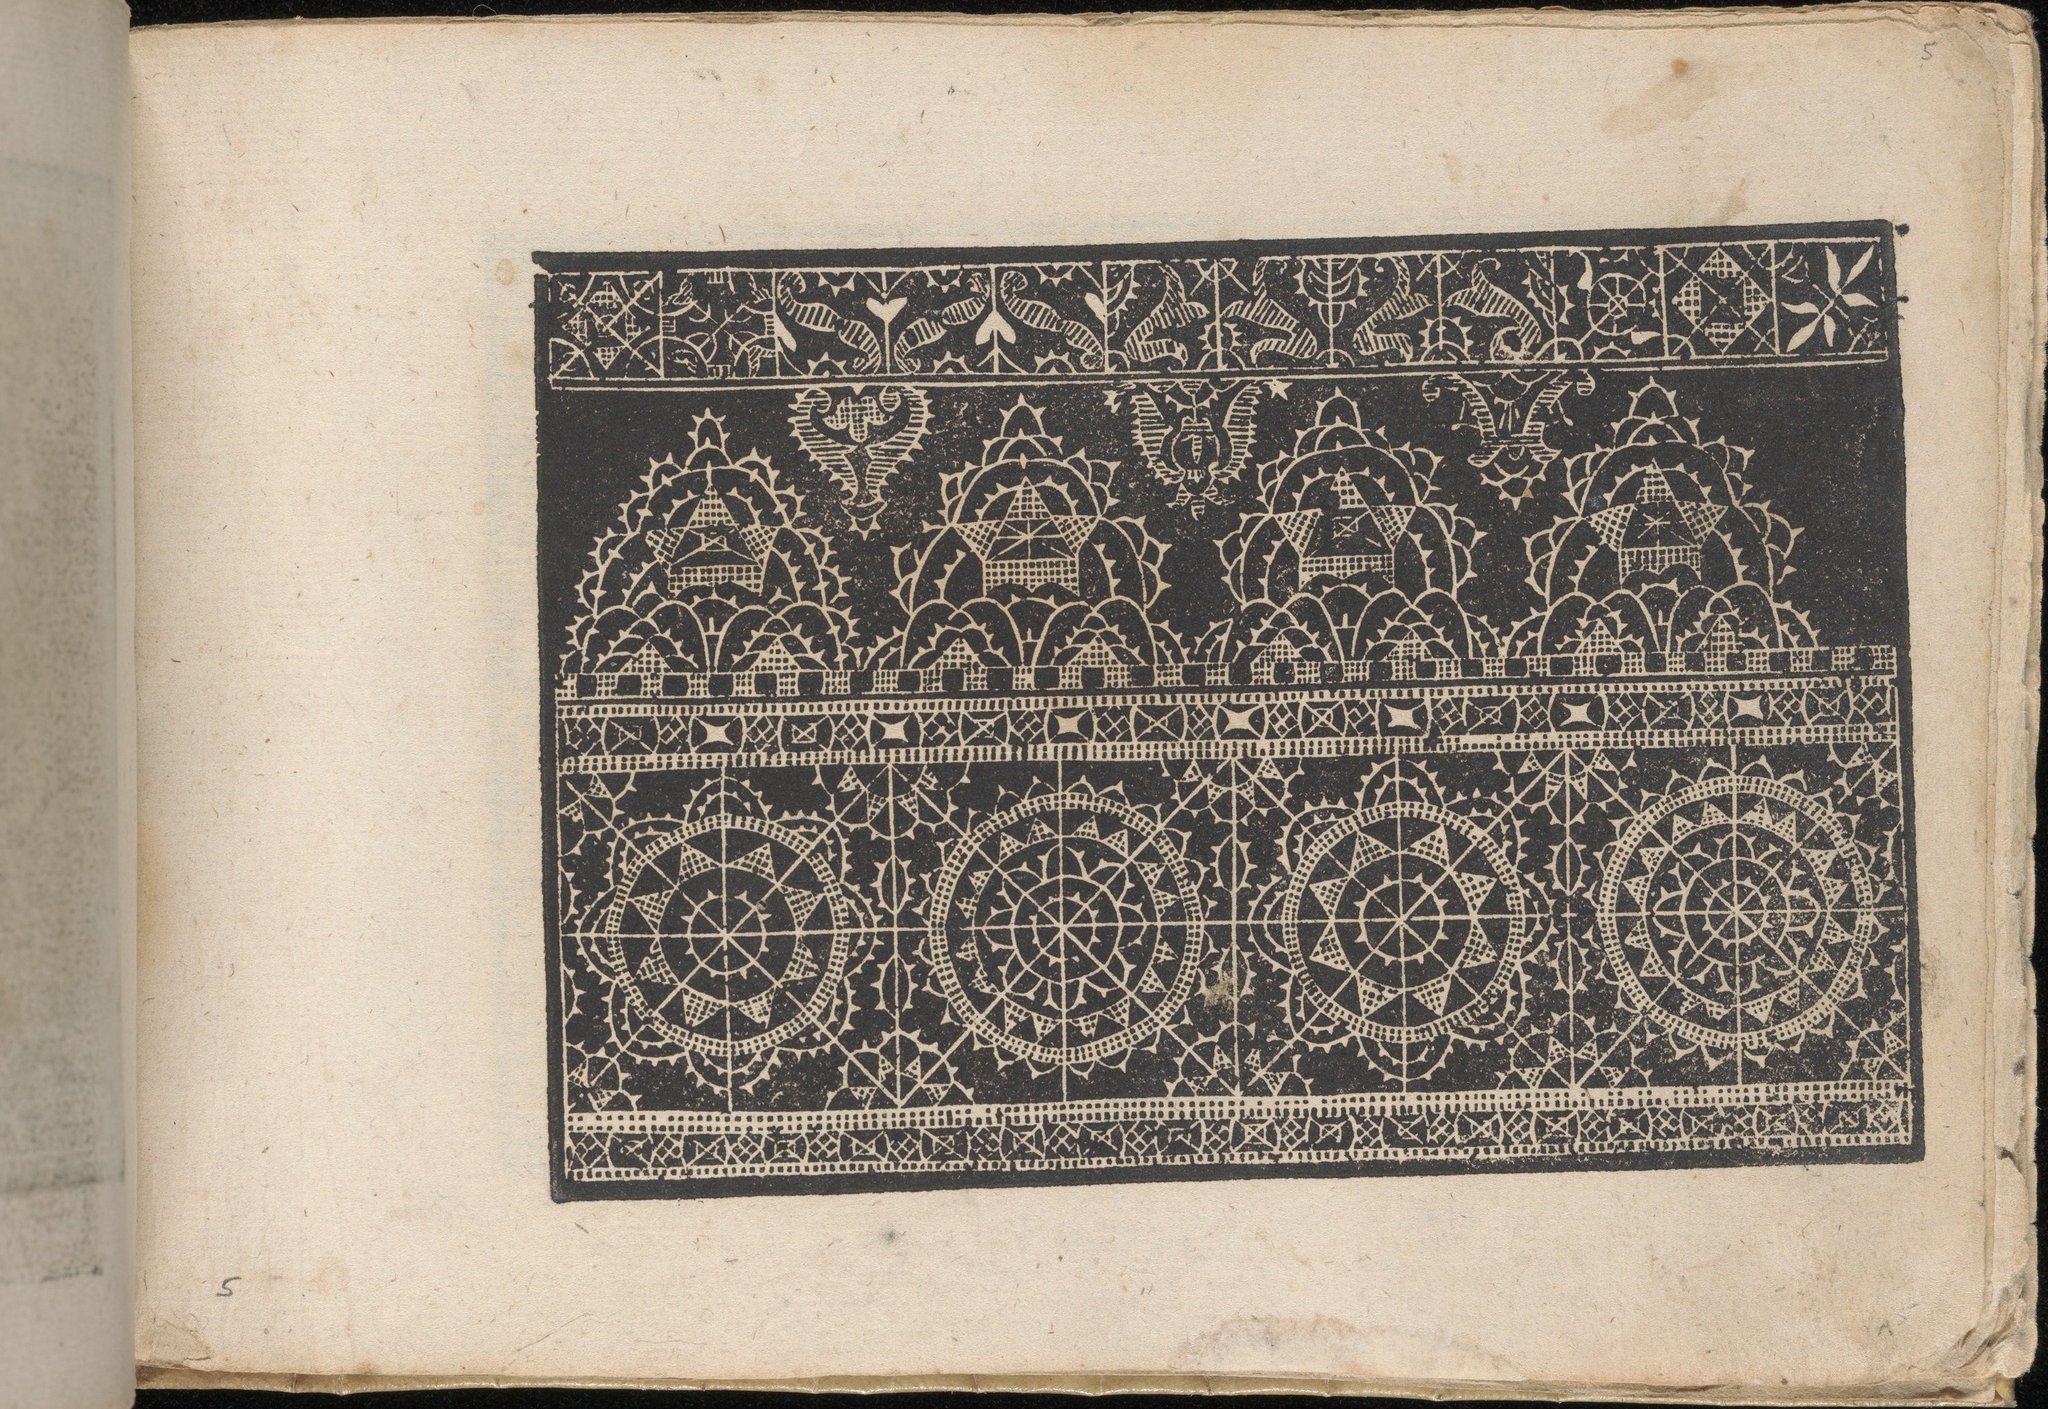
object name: book print ornament archiecture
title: Fiori di Ricami Nuovamente Posti in Luce, page 5 (recto)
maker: matteo florimi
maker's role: designer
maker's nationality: italian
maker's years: 1581-1613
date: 1591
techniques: woodcut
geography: italy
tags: ornament